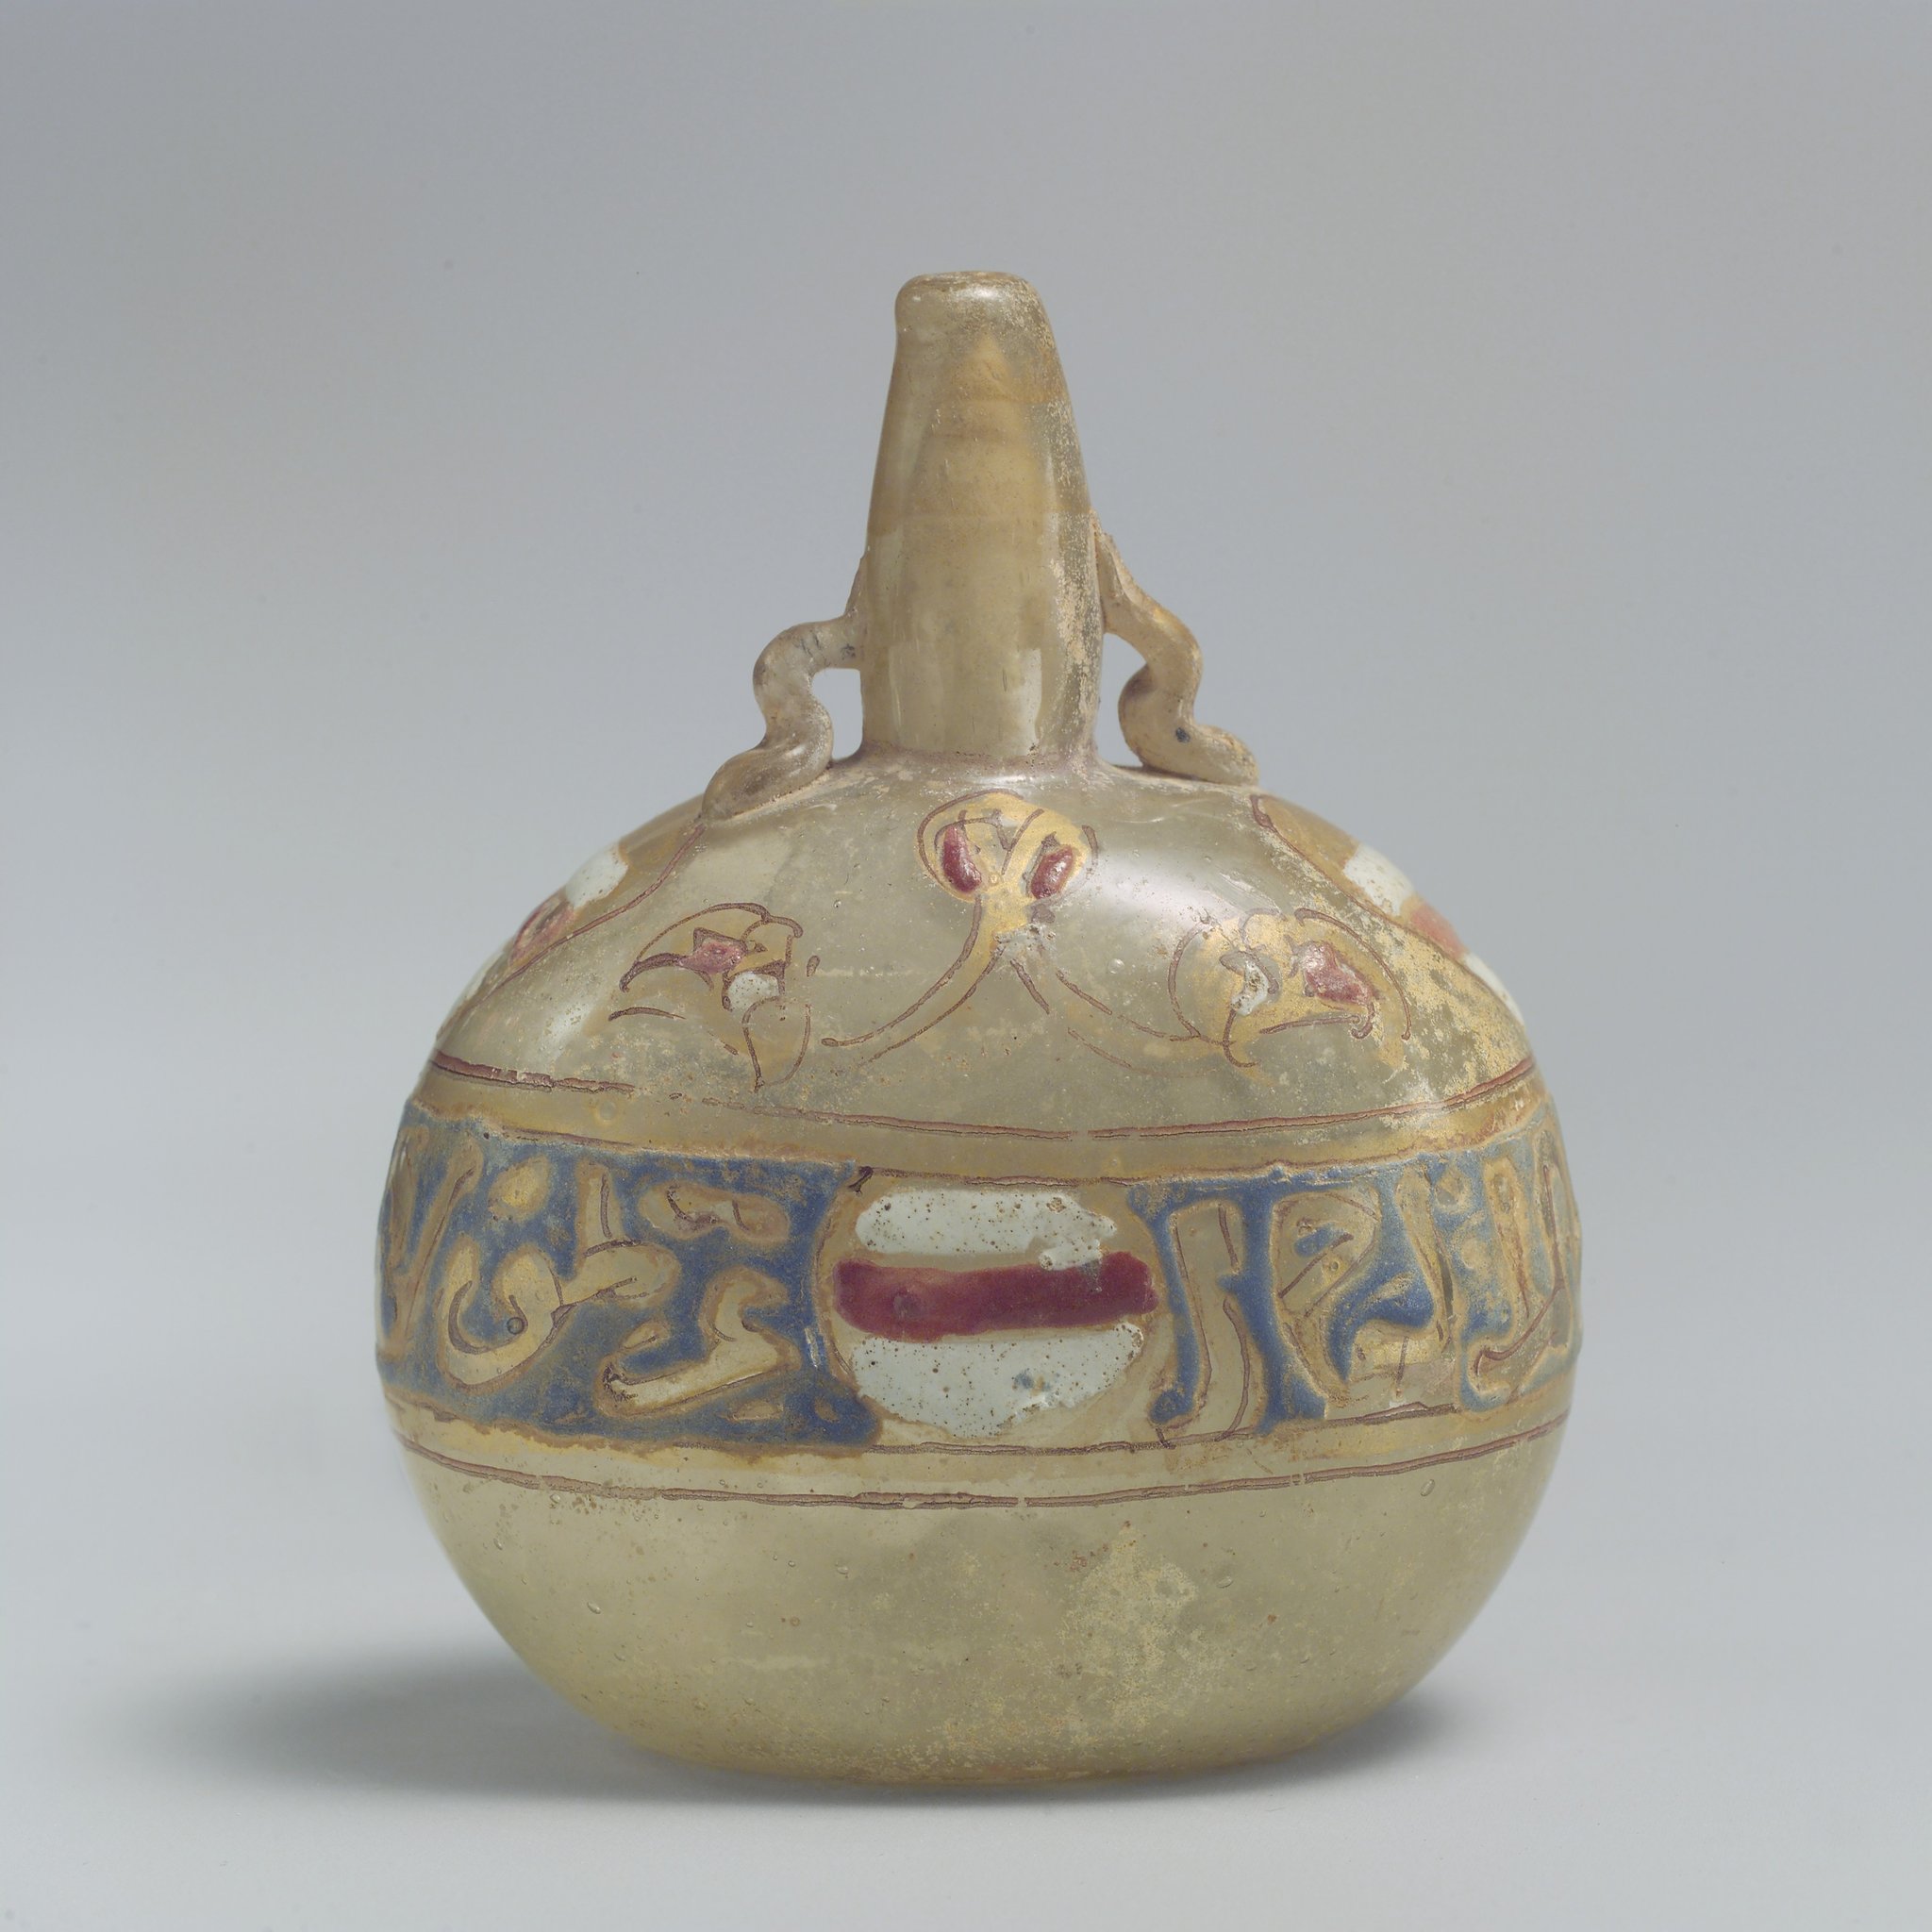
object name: bottle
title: Sprinkler Bottle with Fesse Emblem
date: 1267-1333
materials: glass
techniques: glassblowing, enamel, gilding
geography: egypt